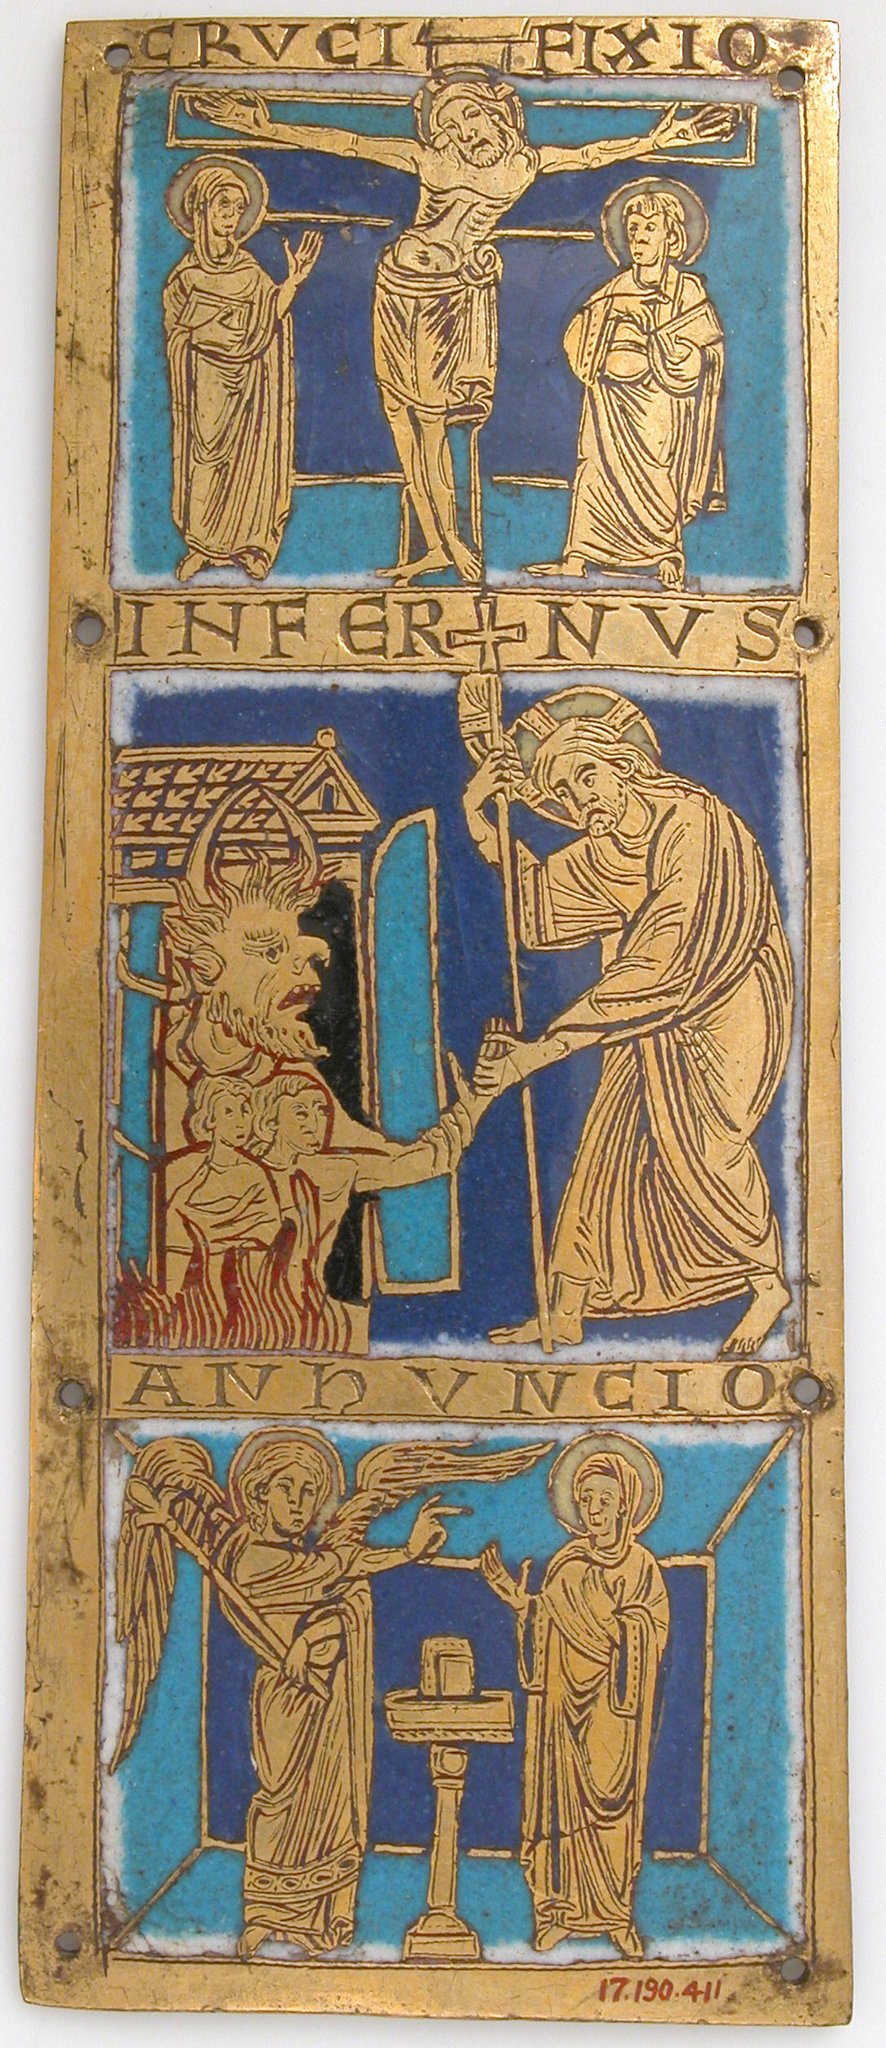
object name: plaque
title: Plaque from a Portable Altar with Scenes from the Life of Jesus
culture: german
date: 1160-1180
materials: gilt copper, enamel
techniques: enamel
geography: germany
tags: angels,christ,demons,annunciation,crucifixion